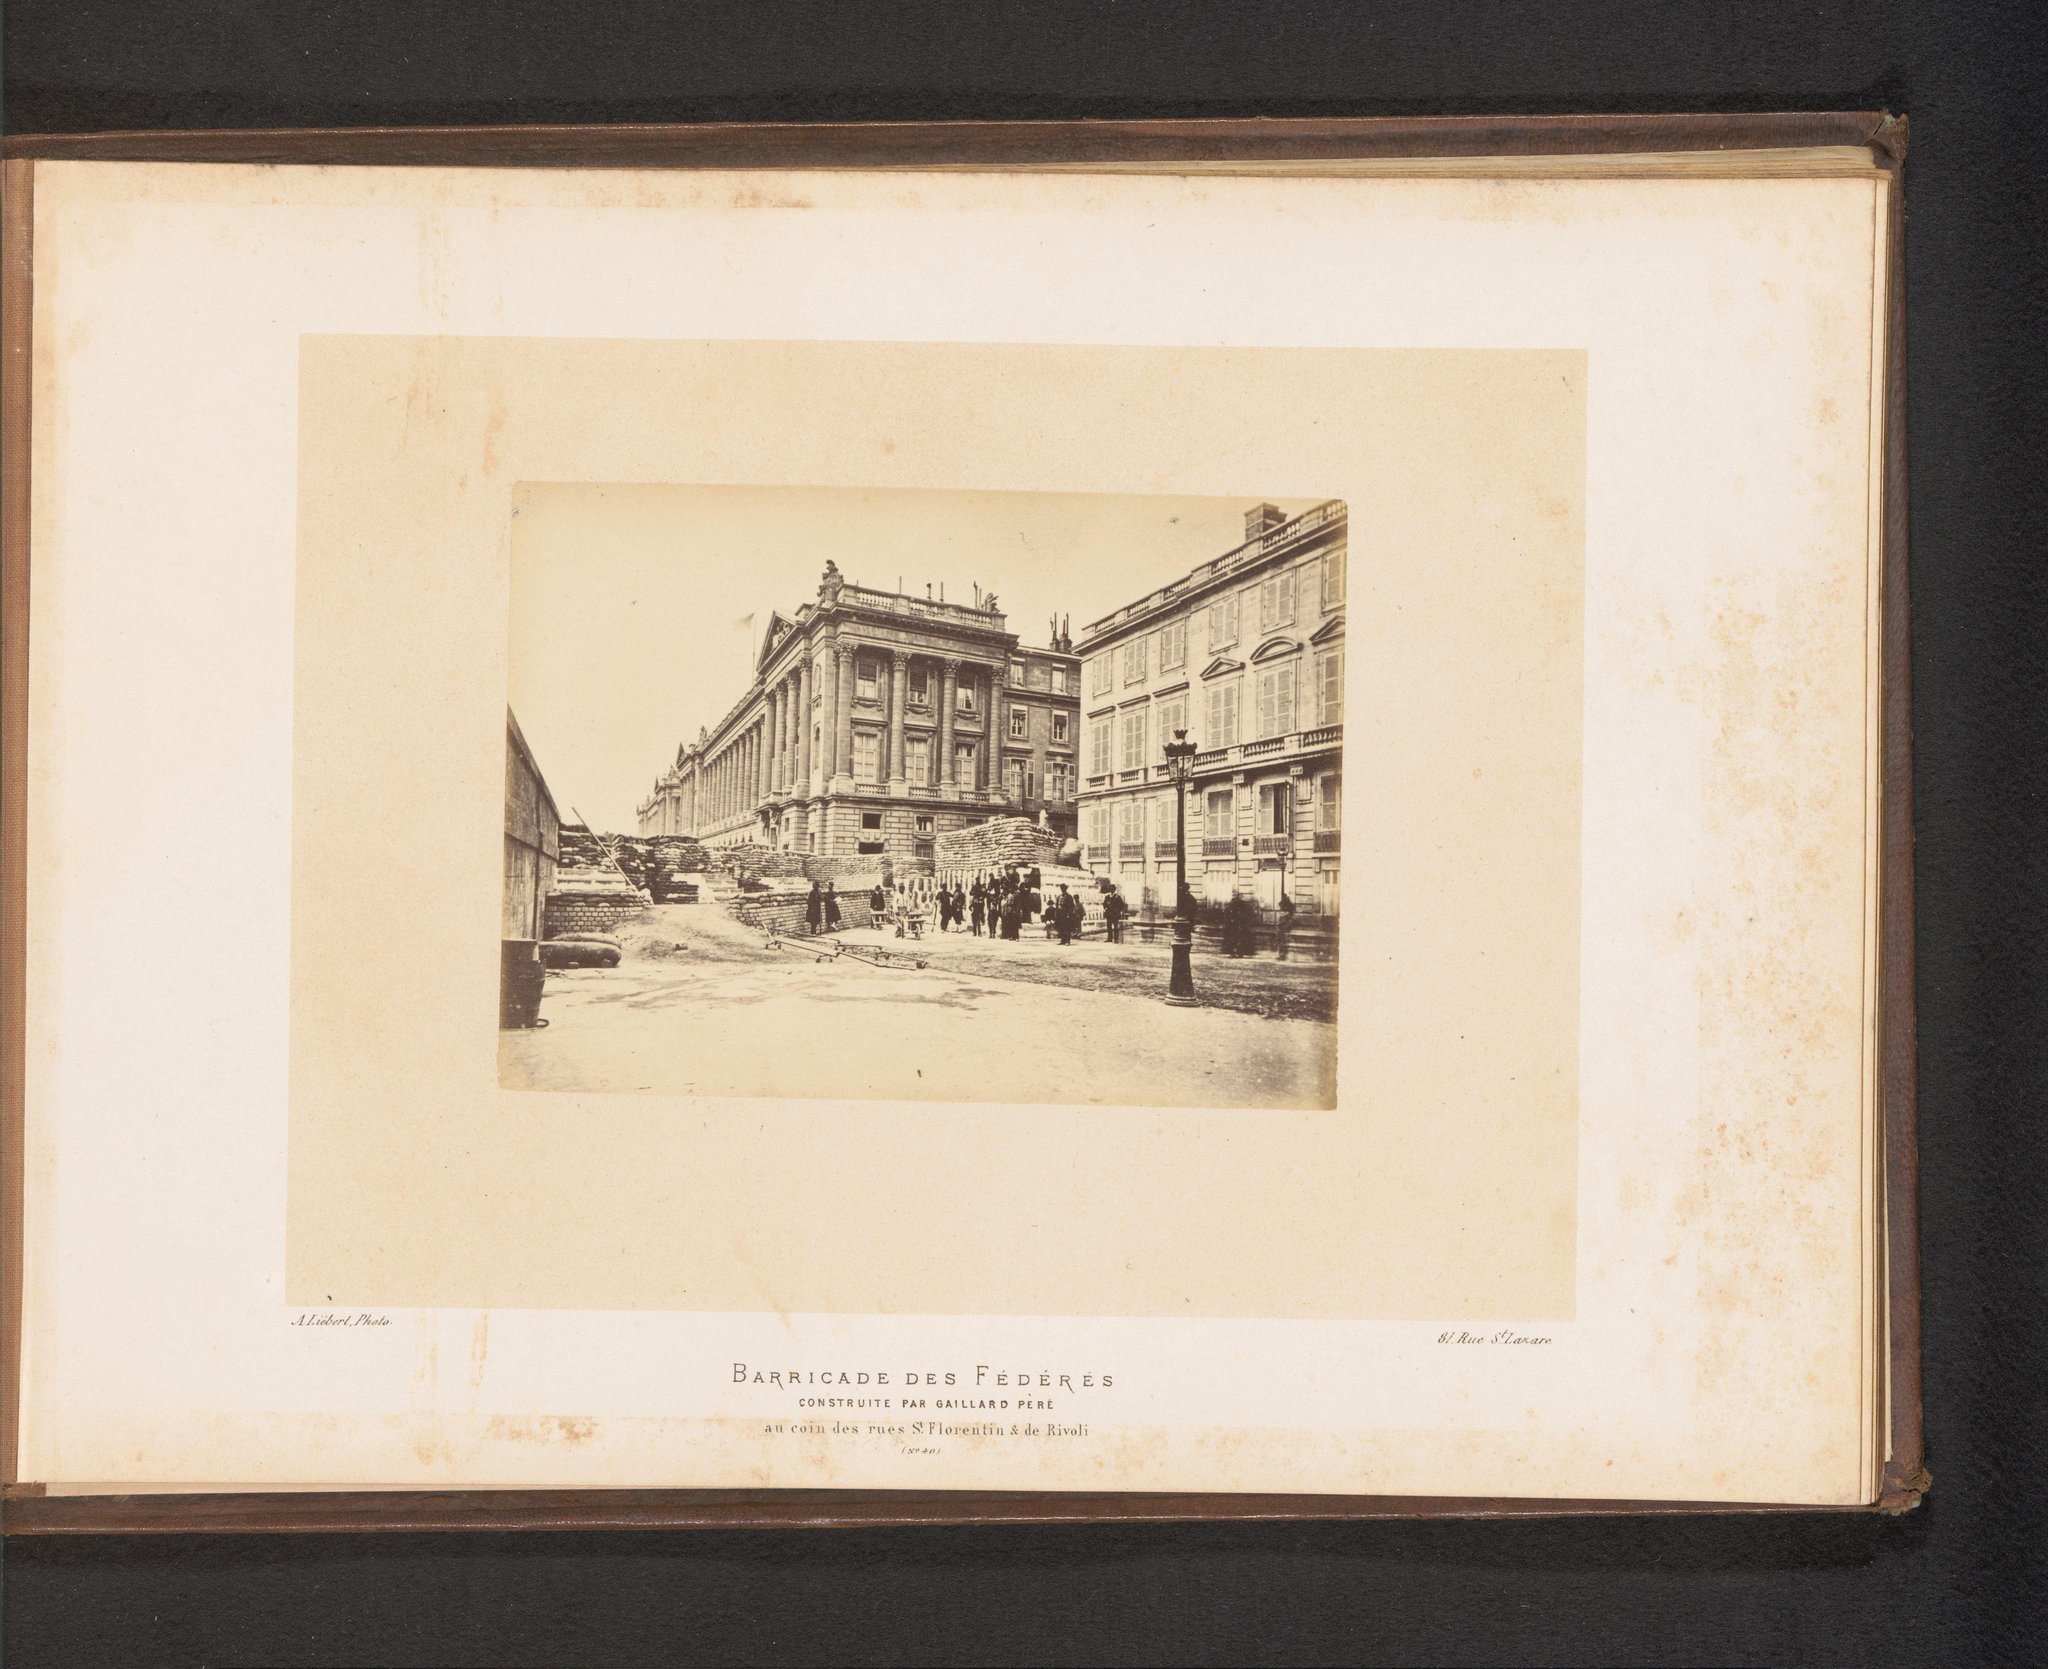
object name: page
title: Barricade des Fédérés construite par Gaillard Père au coin des rues St. Florentin & de Rivoli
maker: alphonse-justin liébert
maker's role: fotograaf, marinier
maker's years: 1827-1914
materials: photographic support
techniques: albumen print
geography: paris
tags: obstructions in streets; barricades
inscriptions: address: ‘31, Rue St. Lazare’, number: ‘(No. 40)’